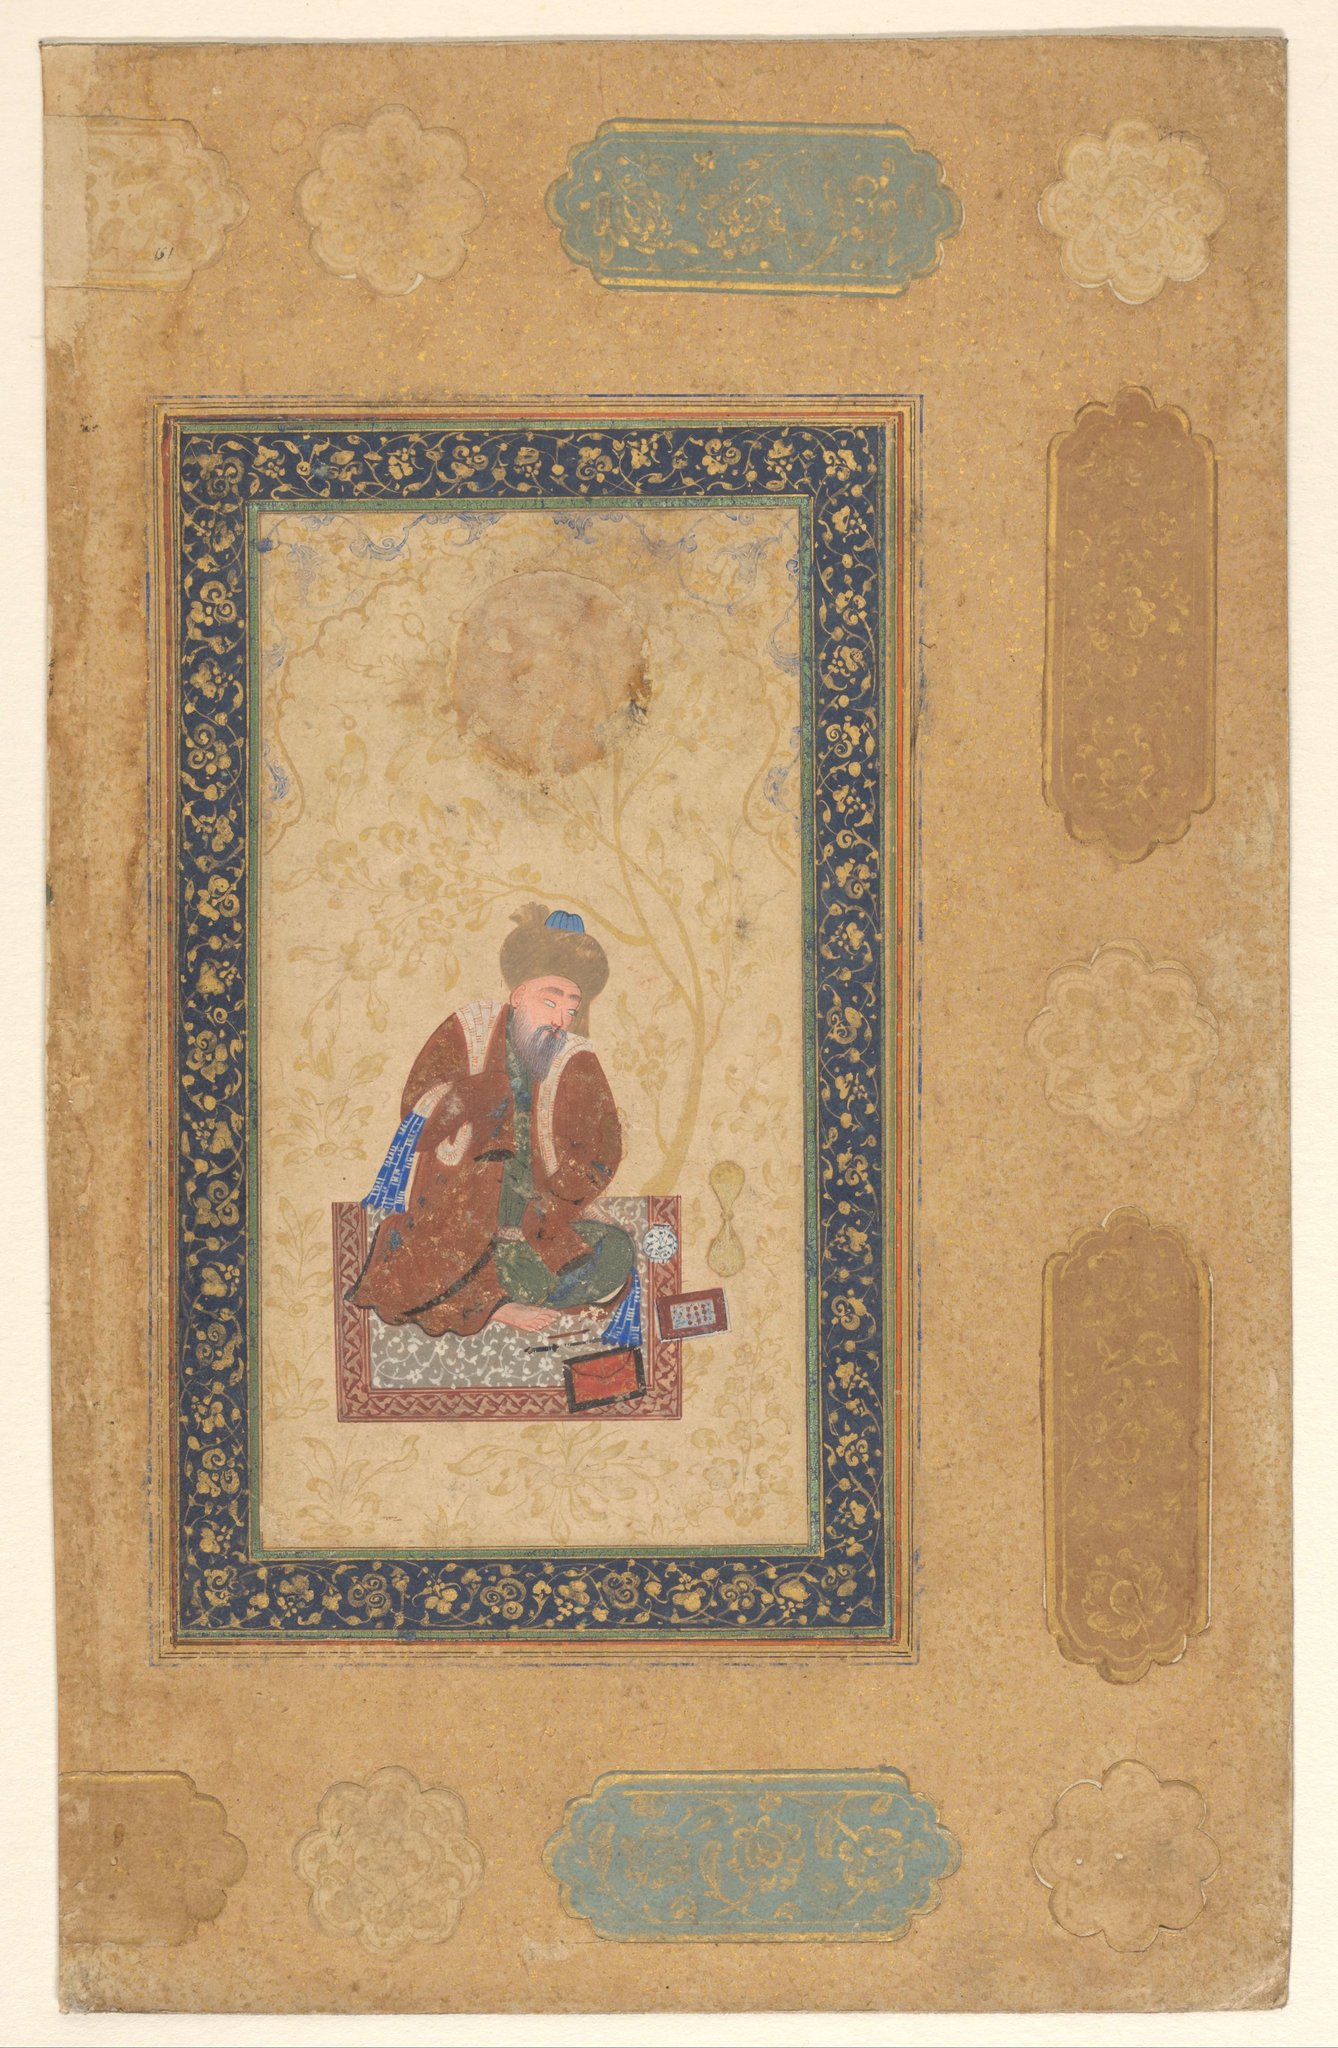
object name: drawing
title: Eenvoudig gekleed persoon met schrijfbenodigdheden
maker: Anonymous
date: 1500-1699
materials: paper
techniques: brush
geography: iran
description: In een kader van een smalle sierrand in donkerblauw met gouden bloem- en bladranken zit een eenvoudig gekleed persoon op een smal tapijt, voor hem op de vloer liggen schrijfbenodigdheden en een blad van een manuscript, op de achtergrond gouden en enkele donkerblauw gekleurde bladranken en een goudkleurige boomstam met een (zwaar beschadigde) zon bovenin; de buitenste rand van het blad is goudkleurig gestippeld en bevat uitgeknipte en opgeplakte inzetstukken in hemelsblauw en sepia met goudkleurige ornamenten. De voorstelling is aan de linkerkant van het blad ingeplakt binnen de kaderlijn en lijkt een deel te zijn van een pendant waarop de randversiering door moet lopen.